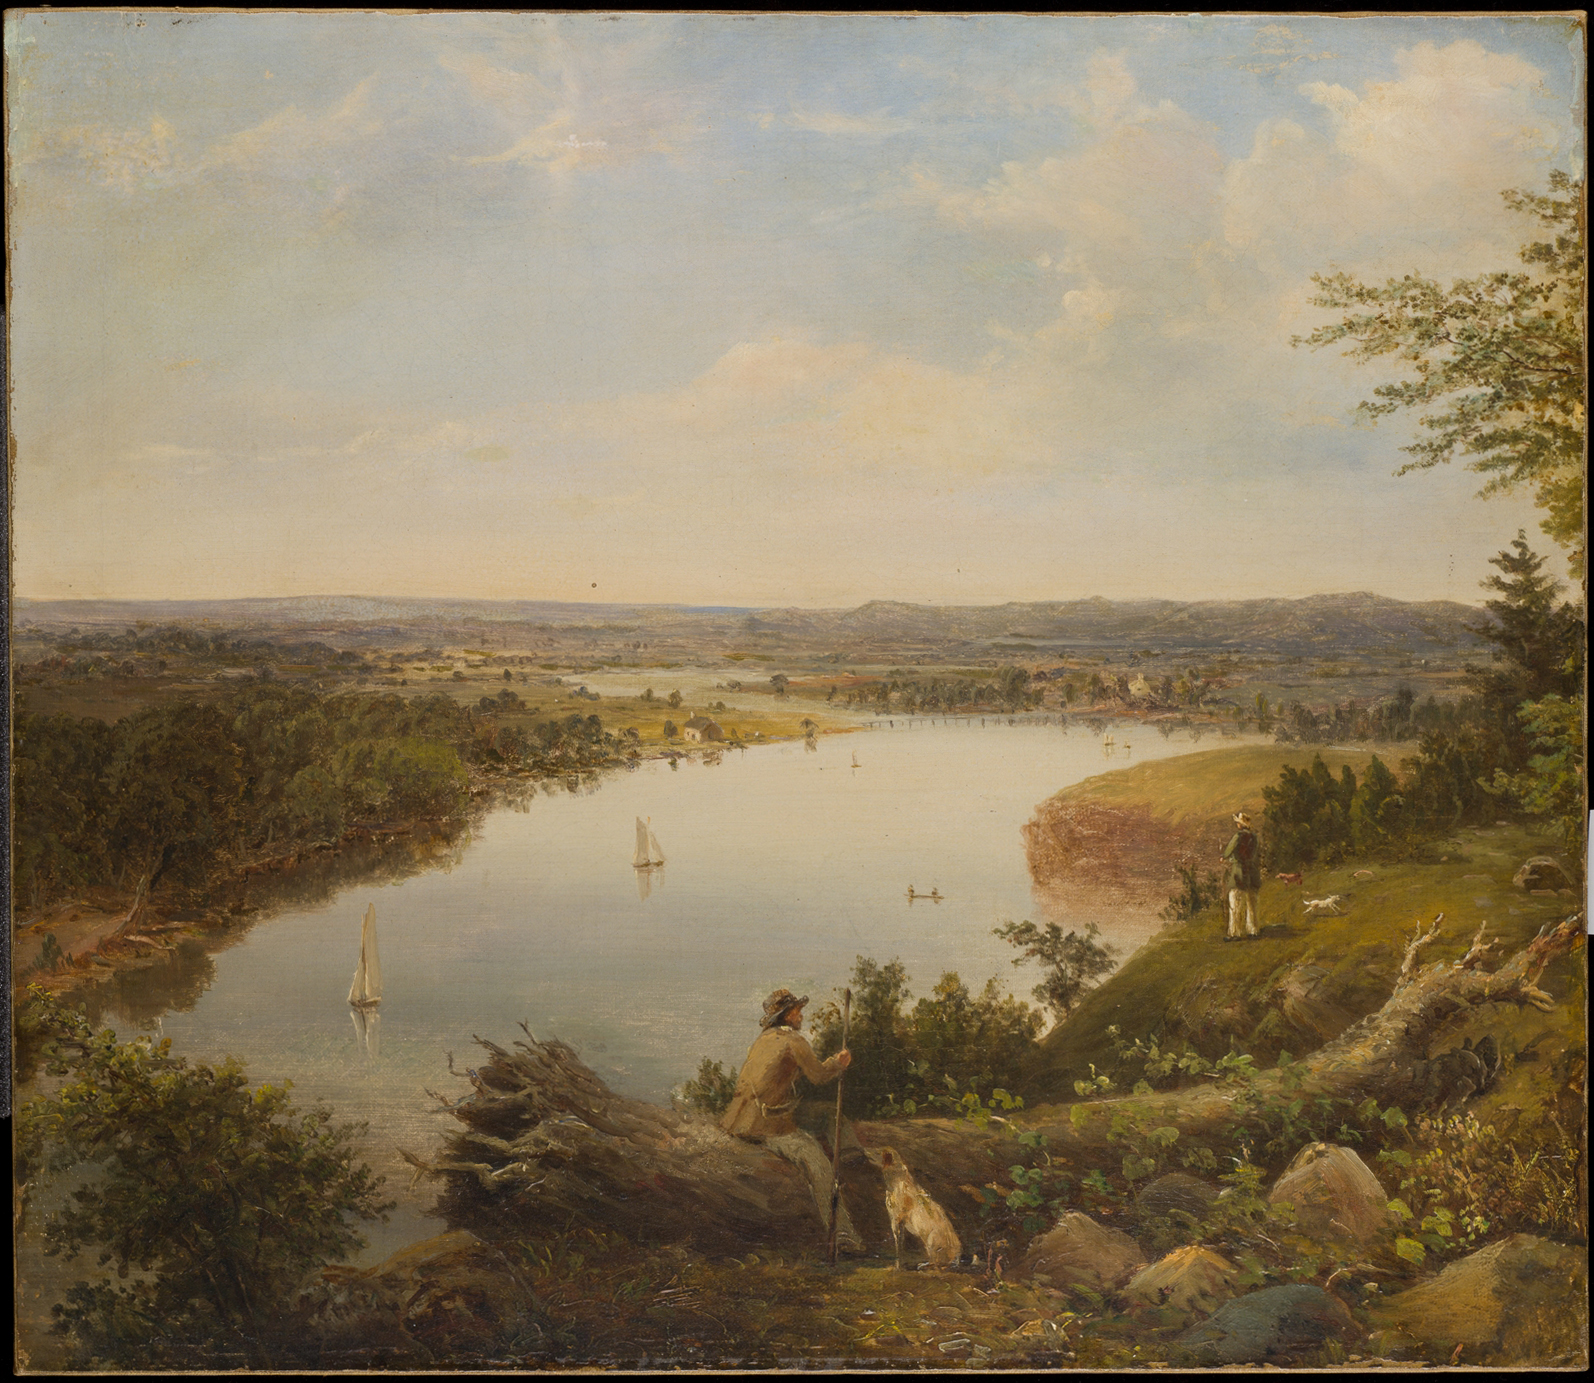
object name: painting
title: The Hudson River Valley near Hudson, New York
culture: american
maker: american painter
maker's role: artist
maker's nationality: american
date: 1850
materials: canvas, oil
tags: rivers,landscapes